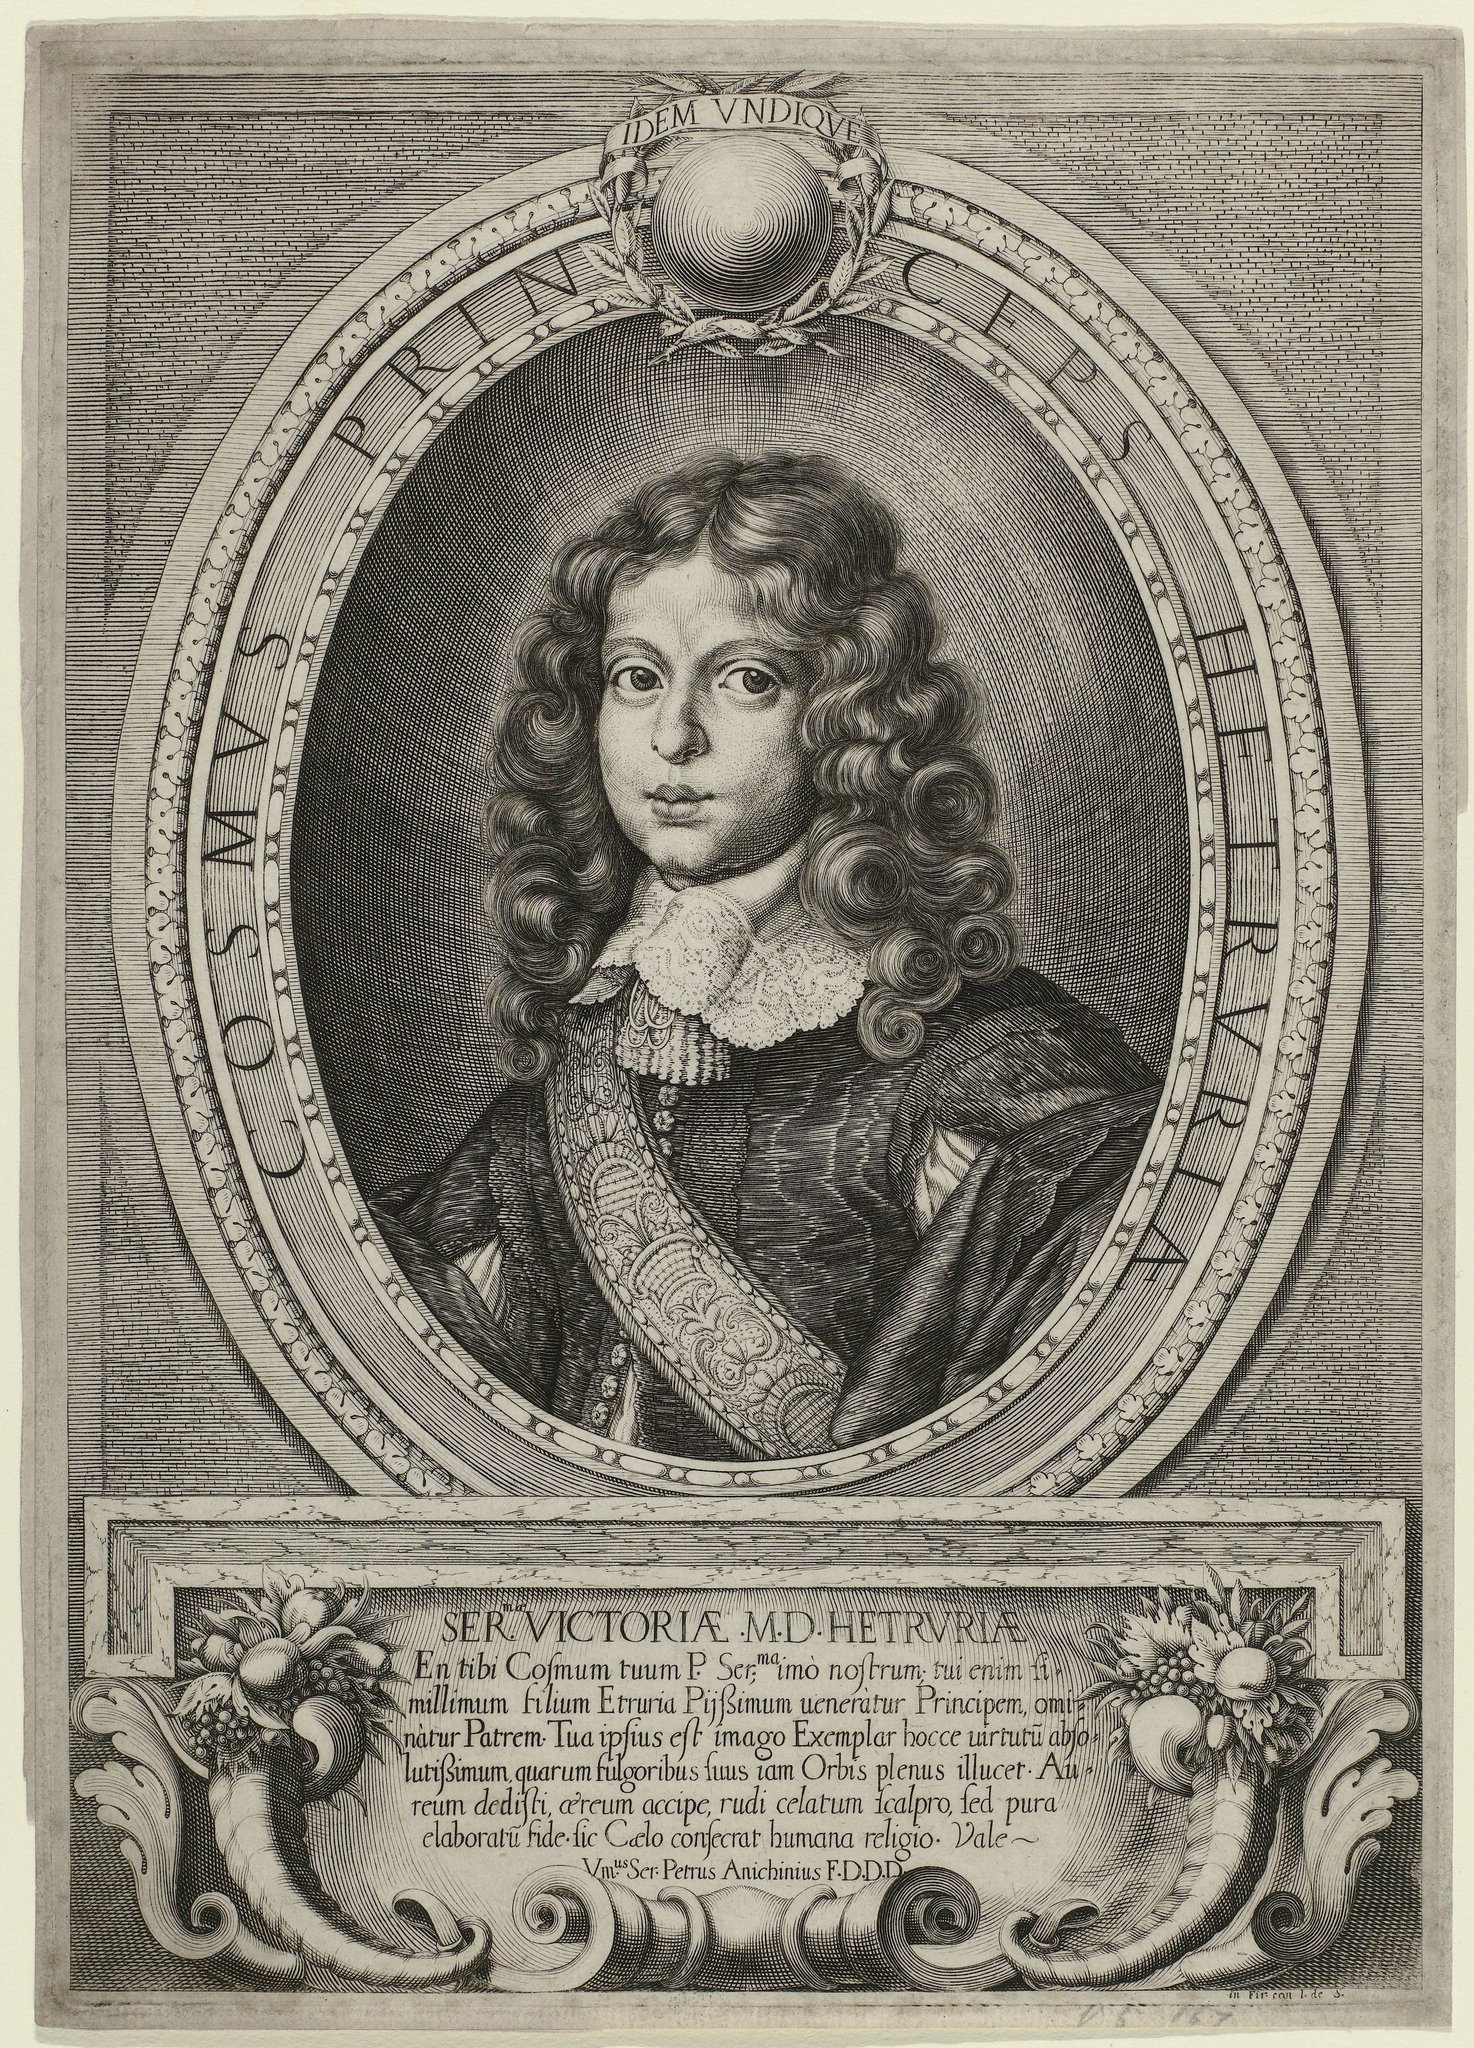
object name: print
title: Portrait of the Young Cosimo III de’ Medici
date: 1655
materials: paper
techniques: engraving, etching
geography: florence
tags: cosimo iii de' medici, historical persons, ruler, sovereign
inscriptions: collector's mark: Lugt 2229, inscription: ‘P. Mariette 1678’, watermark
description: This endearing portrait features the thirteen-year-old Cosimo III de’ Medici, who would become Grand Duke of Tuscany in 1670. The Florentine engraver Pietro Anichini executed it according to his own design. The young Cosimo would have posed for him. In the Latin inscription, Anichini addresses Cosimo’s father and praises the boy’s physiognomy as exemplifying the virtues of the reigning Grand Duke of Tuscany.